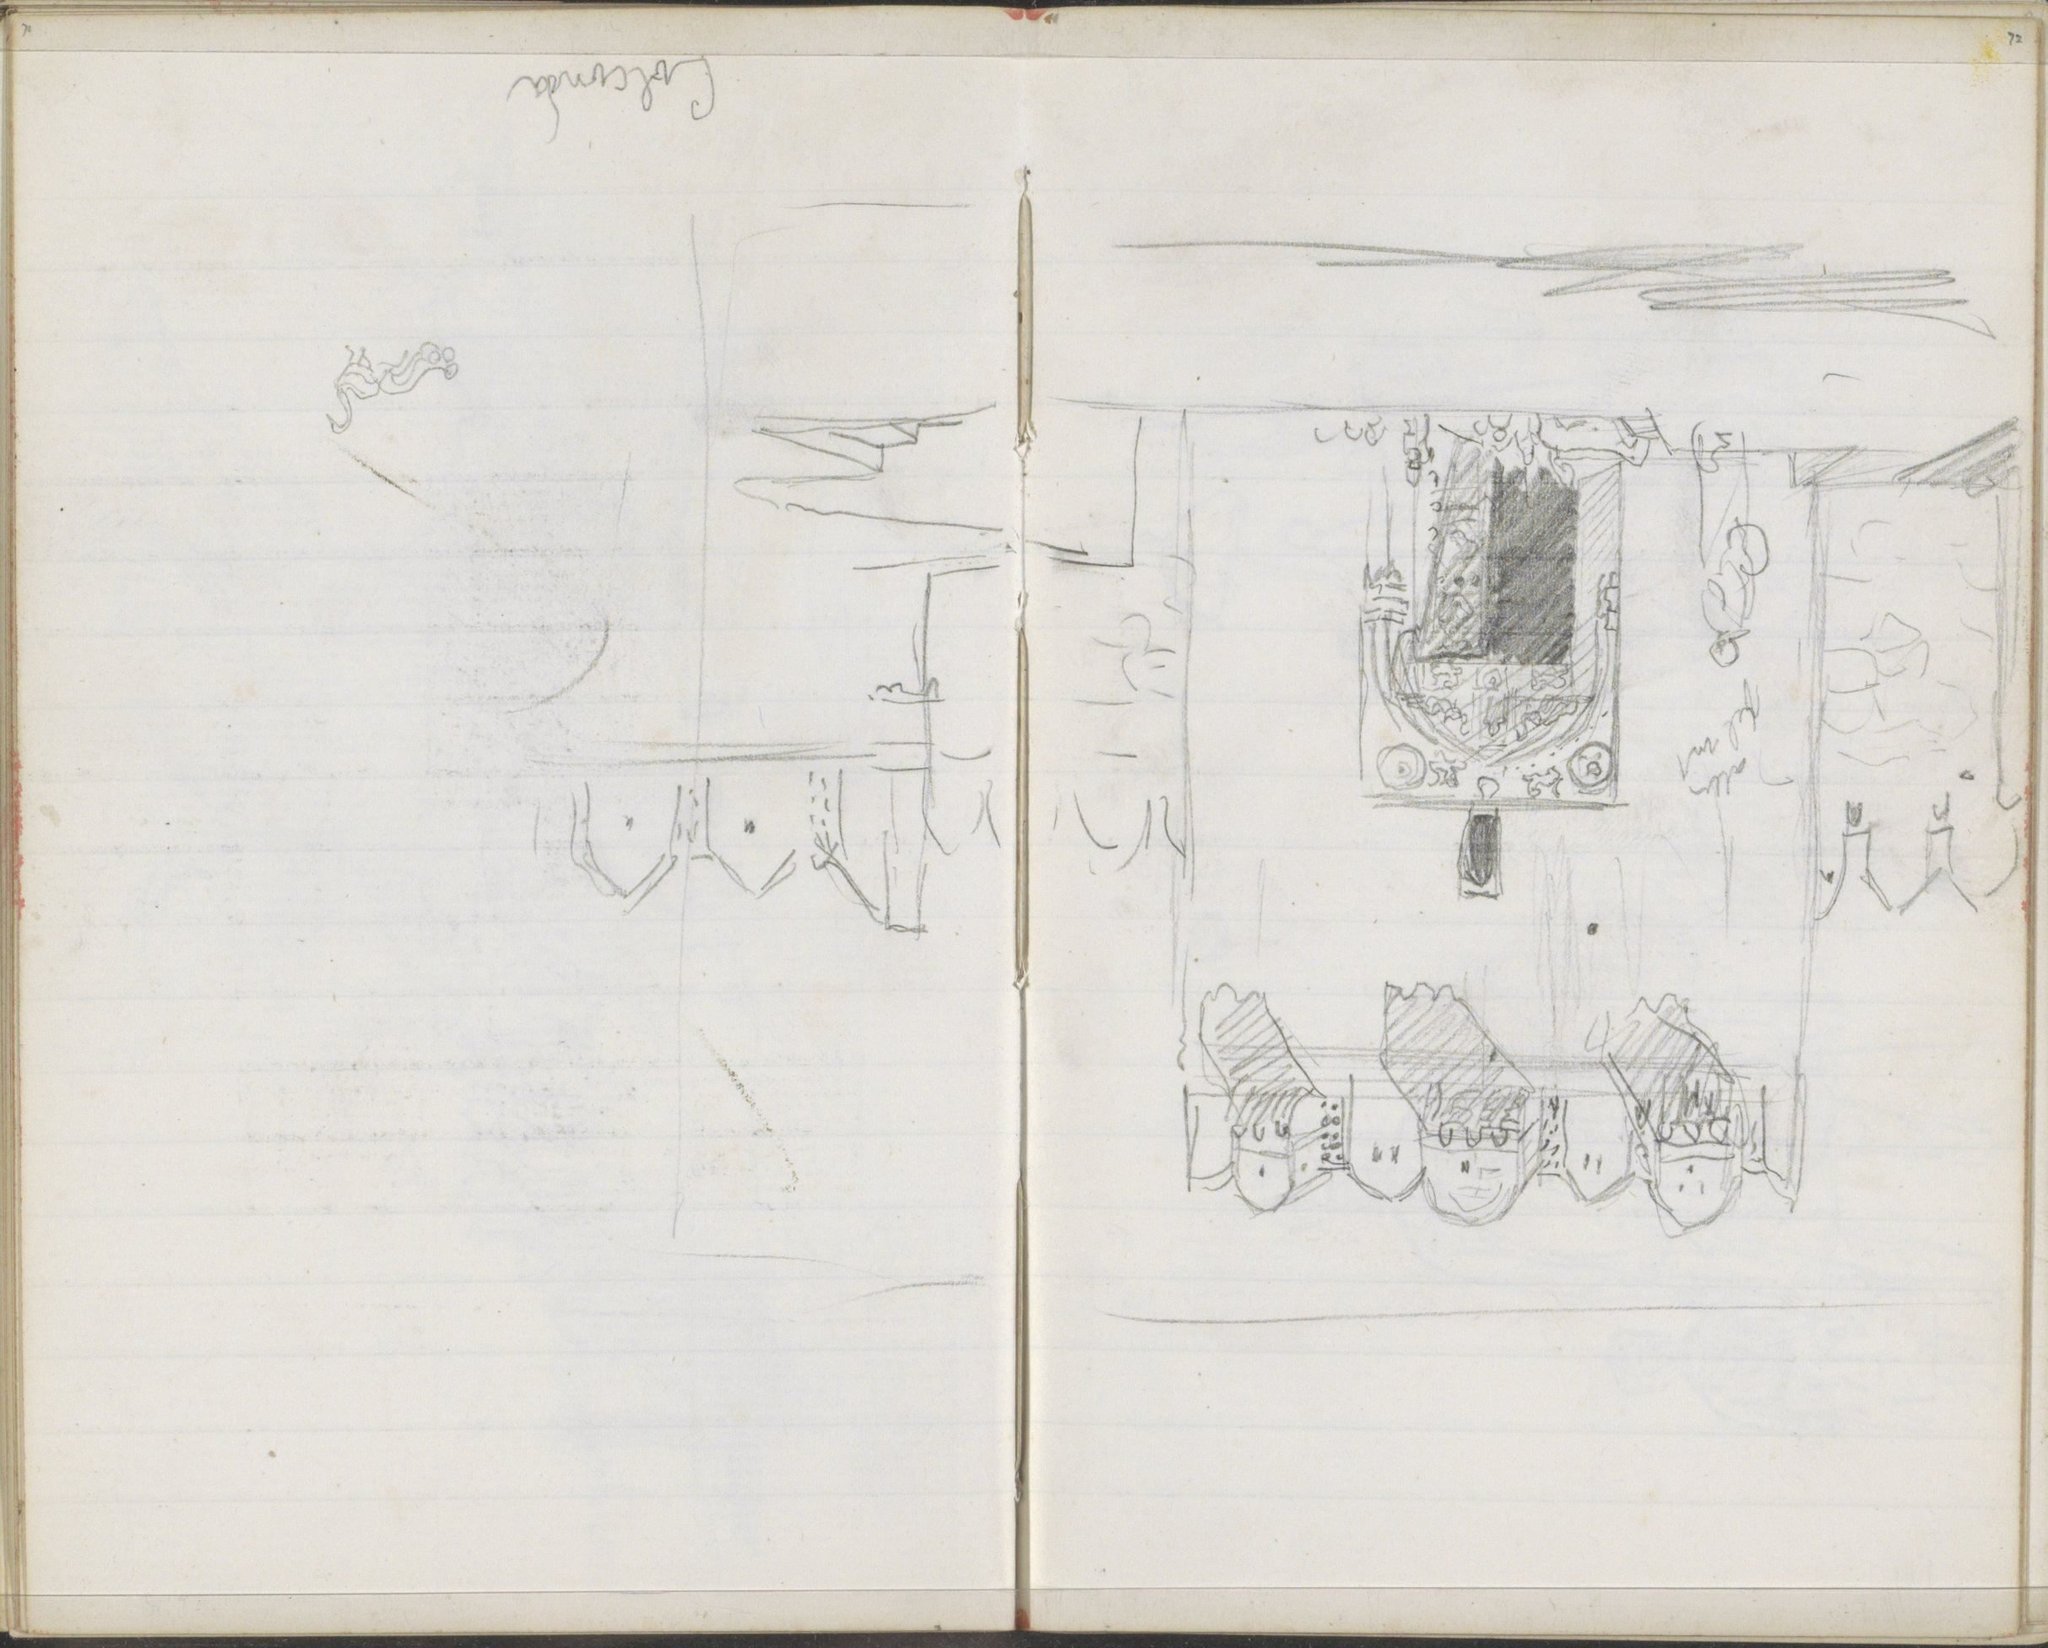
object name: sketchbook leaf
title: Gedecoreerd portaal in Golkonda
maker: marius bauer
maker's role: draughtsman, print maker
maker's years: 1867-1932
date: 1897-1898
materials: pencil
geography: golkonda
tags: architecture, street (+ city(-scape) with figures, staffage)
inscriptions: annotation: ‘Colconda’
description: Bij het portaal staat een figuur. Op de achtergrond zijn de kantelen van een verdedigingsmuur te zien. Pagina 71 en 72 uit een schetsboek met 62 bladen.